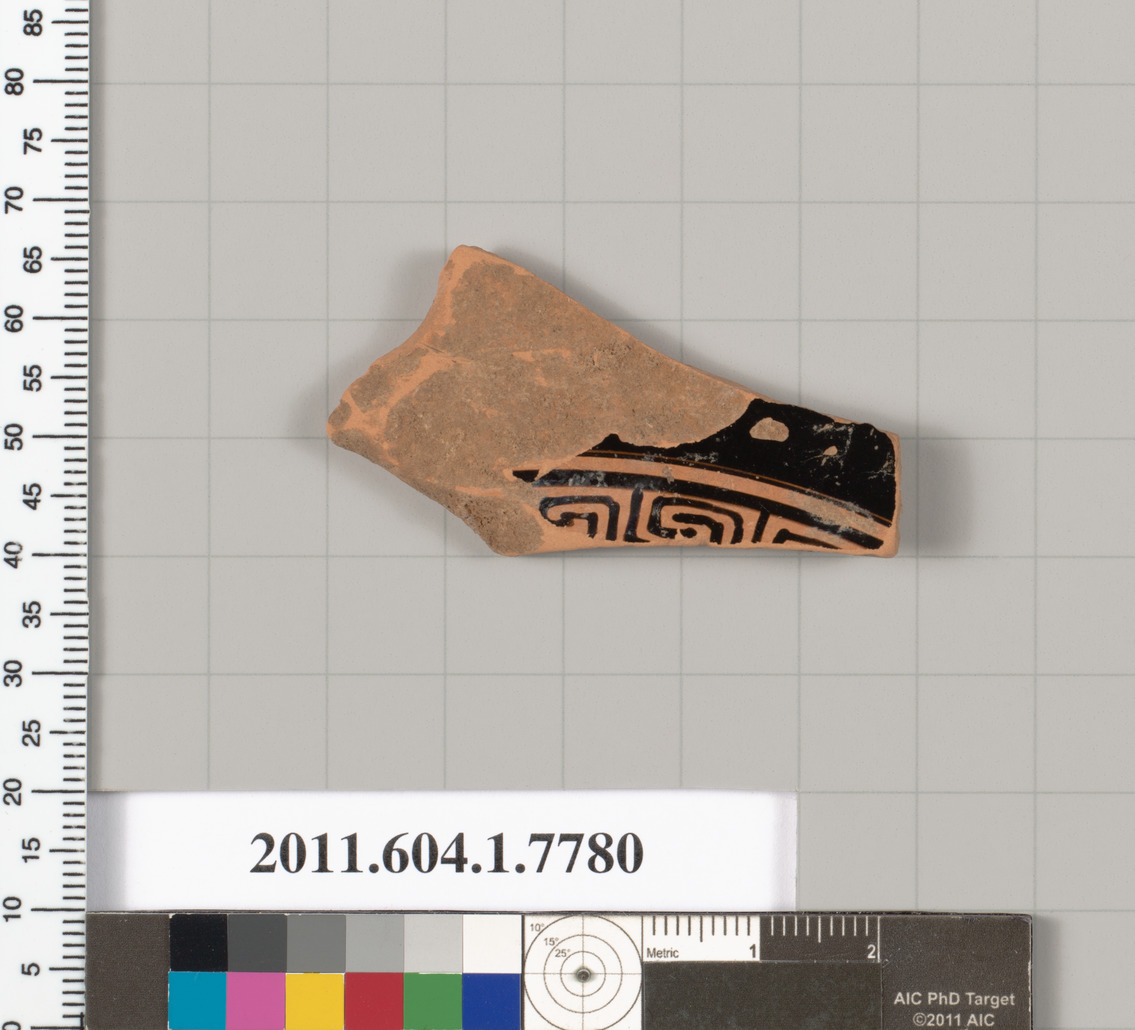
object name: kylix fragment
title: Terracotta fragment of a kylix (drinking cup)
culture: greek, attic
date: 460-450 BCE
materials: terracotta